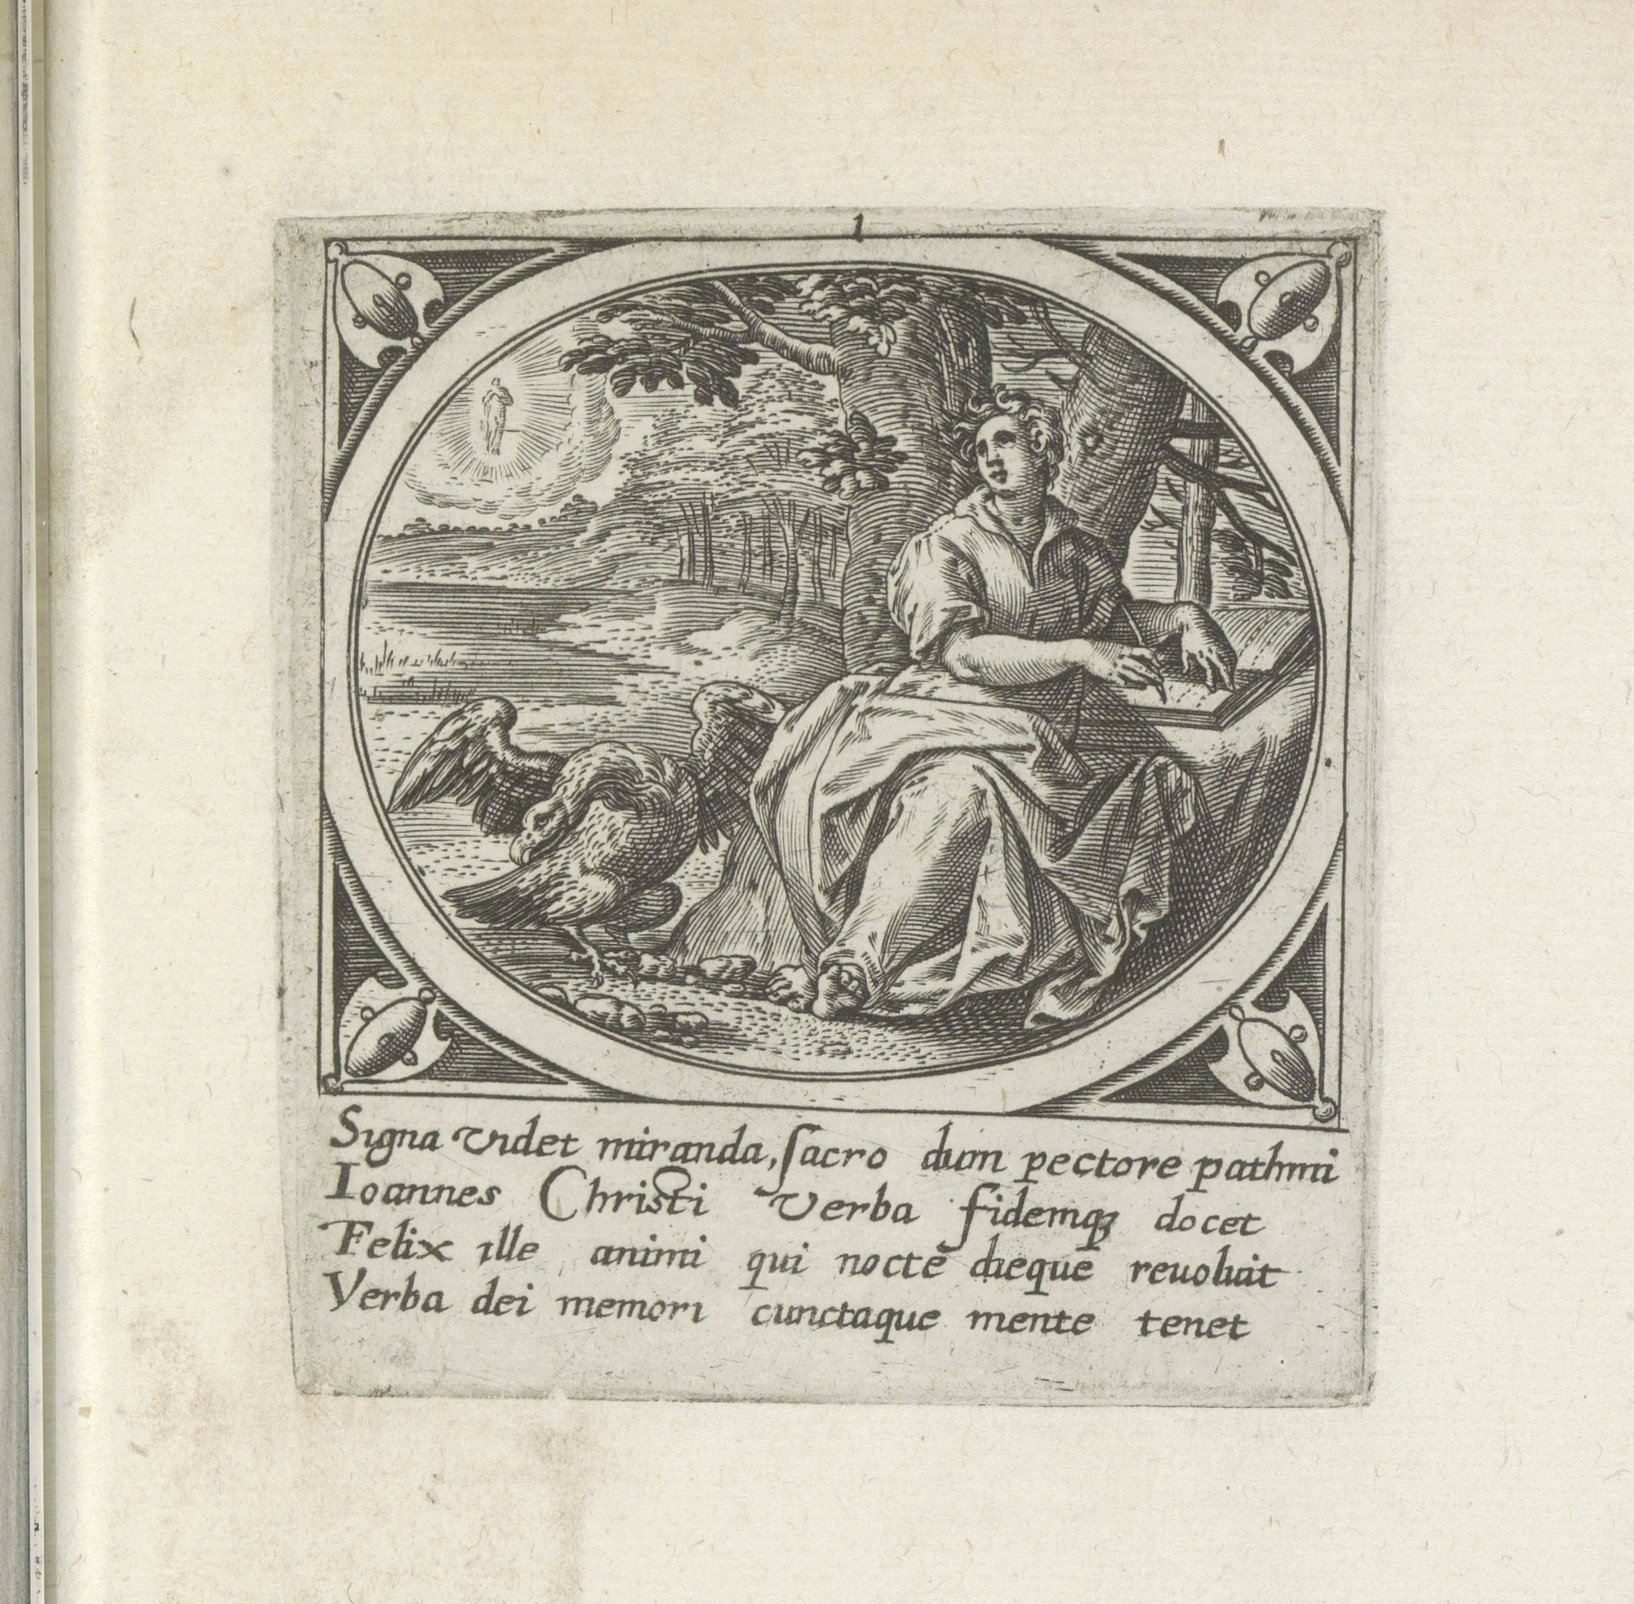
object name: album leaf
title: Thesaurus novi Testamenti elegantissimis iconibus expressus continens historias atque miracula doni nostri Iesu Christi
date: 1585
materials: paper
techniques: engraving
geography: antwerp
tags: john (writing) on the island of patmos, possibly the eagle beside him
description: Johannes de evangelist schrijft op het eiland Patmos zijn openbaringen in een boek. Hij kijkt omhoog naar de hemel naar een verschijning van Christus. Naast Johannes zit de adelaar. Onder de voorstelling een verwijzing in het Latijn naar de Bijbeltekst. Deze prent maakt deel uit van een album.